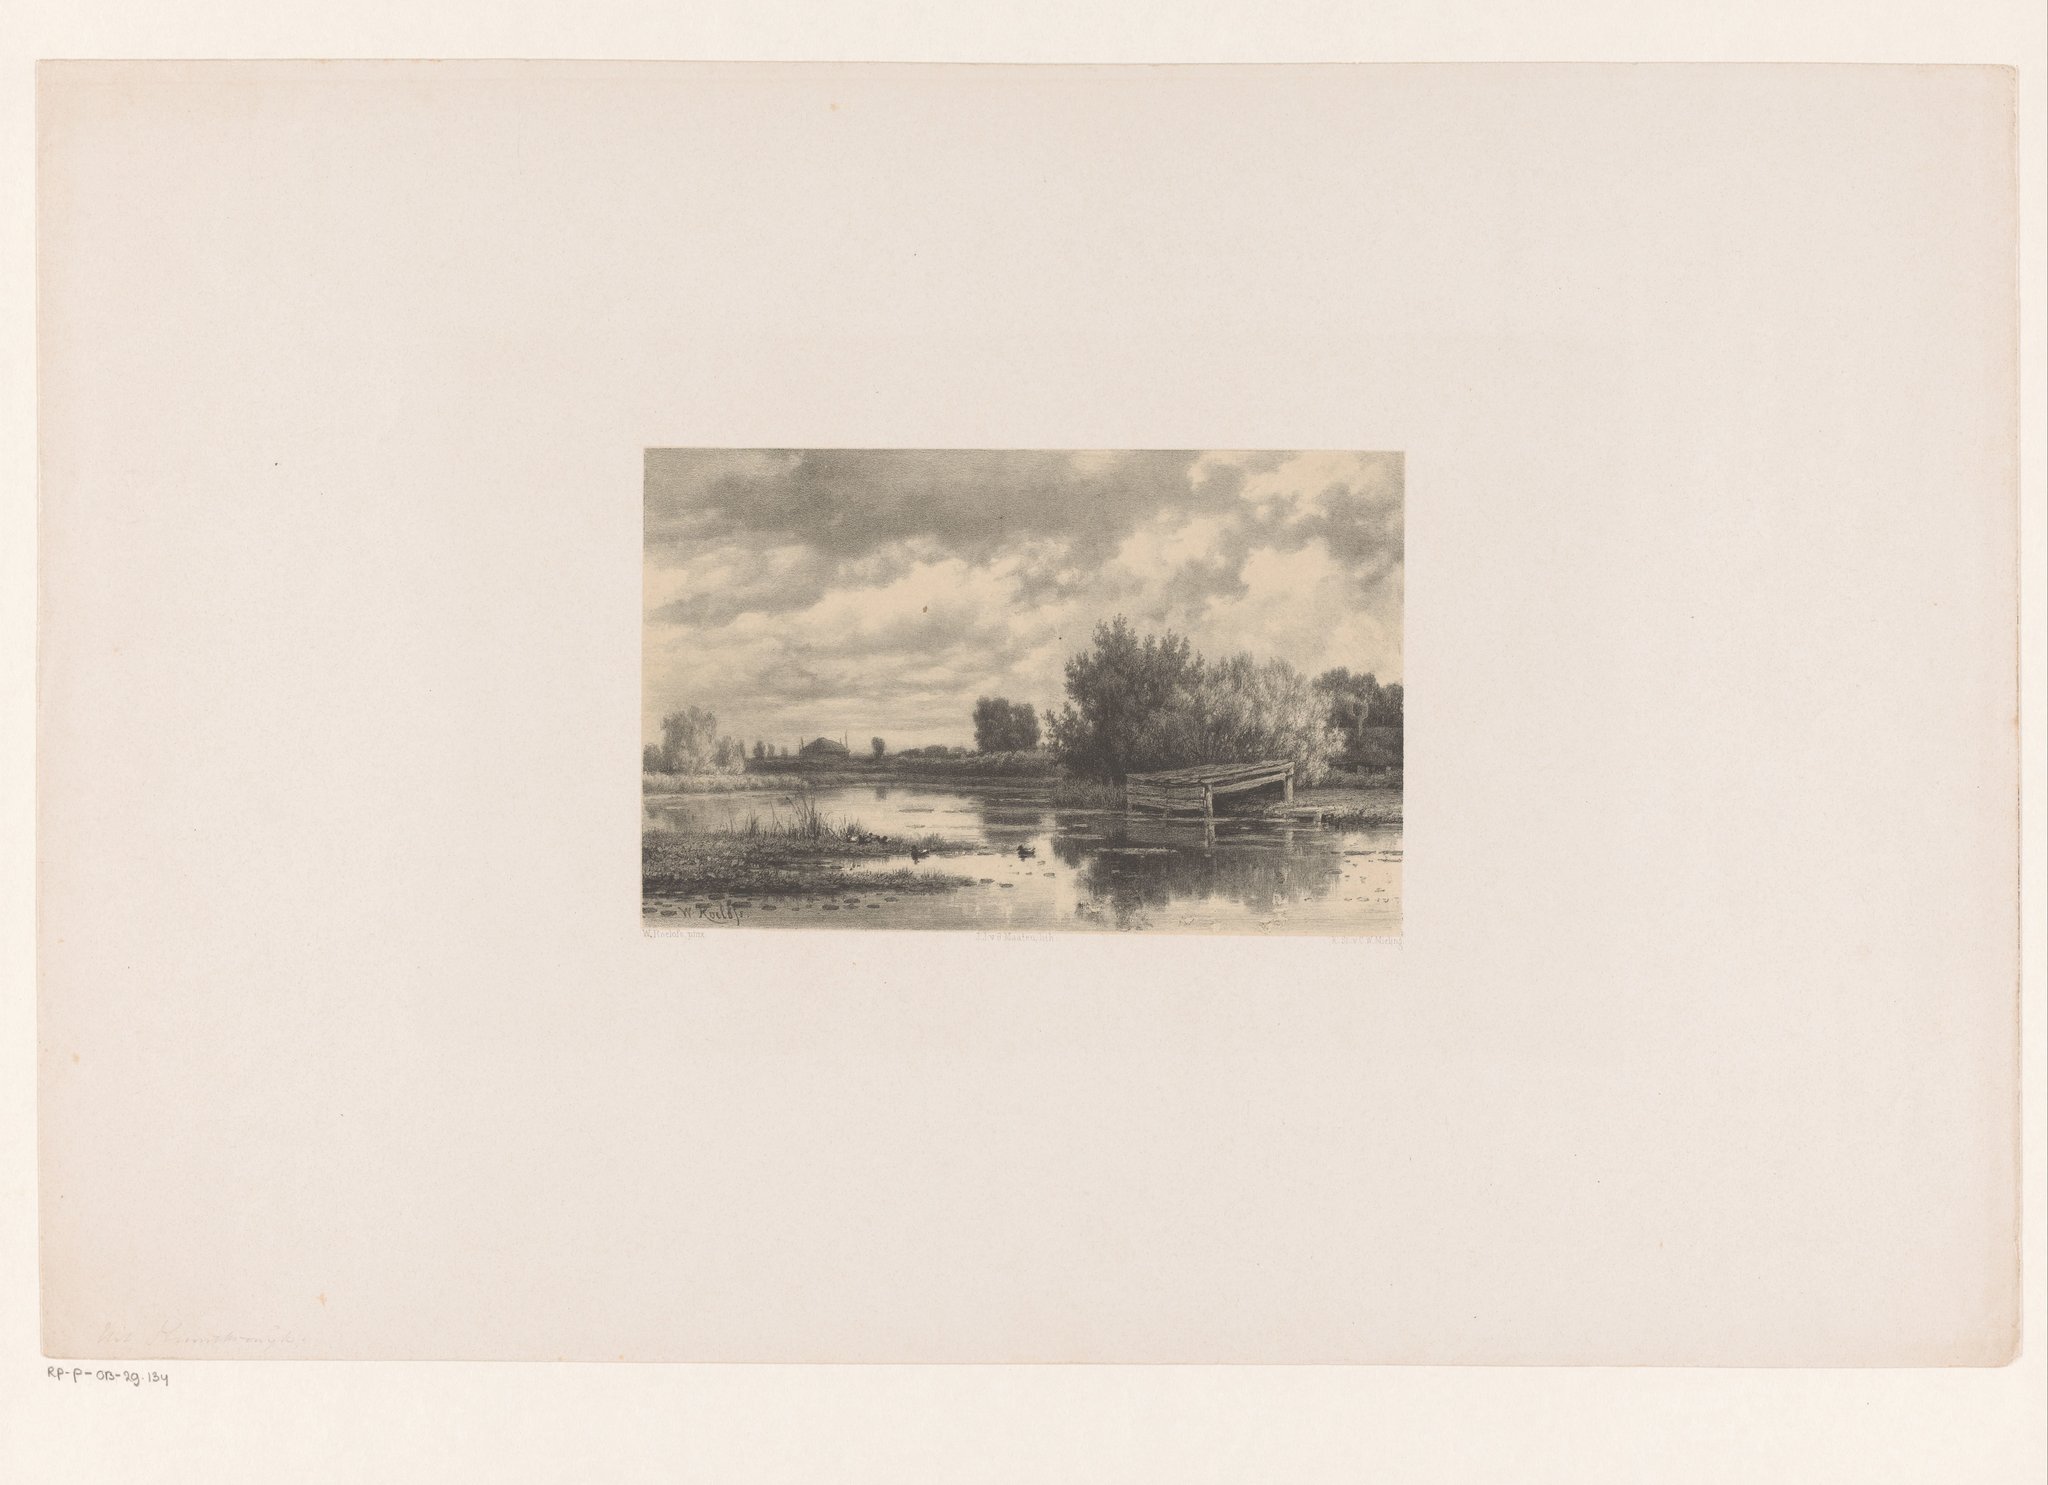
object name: print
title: Rivierlandschap met hooischuur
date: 1830-1865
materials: paper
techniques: tone lithography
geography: the hague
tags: barn, pier, quay, wharf, river (+ landscape with figures, staffage)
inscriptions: collector's mark: Lugt 2228, inscription: ‘Uit Kunstkronijk’